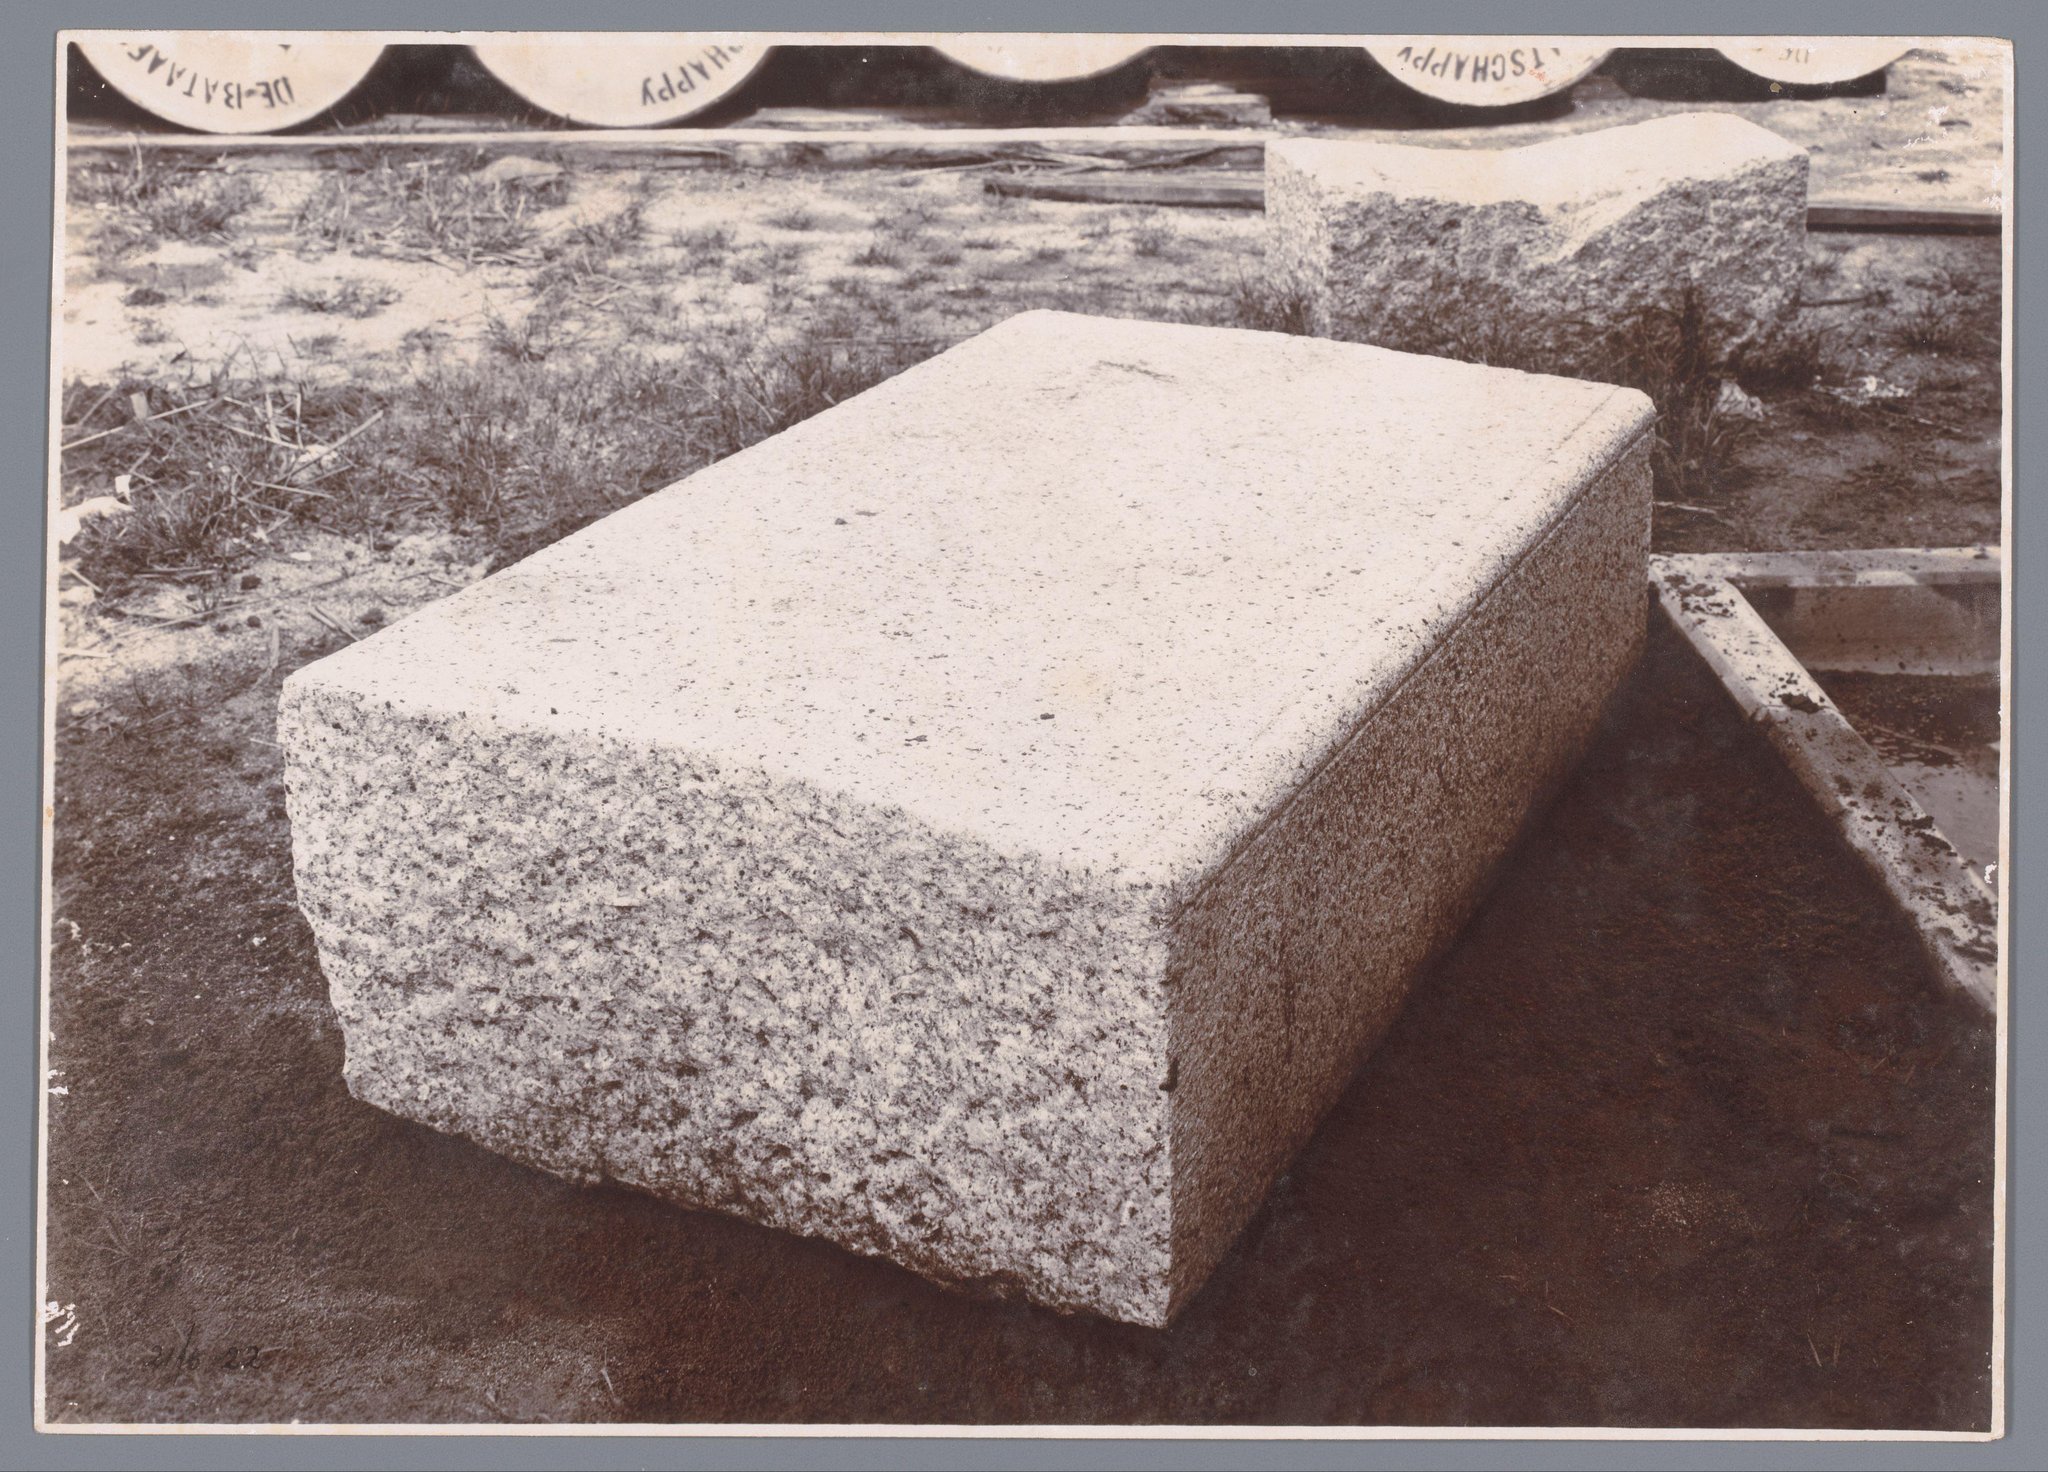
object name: photograph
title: Oceaanhaven Belawan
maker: Anonymous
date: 1906-1922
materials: photographic support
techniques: gelatin silver print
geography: belawan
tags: harbour, stone ~ building material, building-site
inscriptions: inscription: ‘No 173 Monster graniet voor dekzerken’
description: Een afdeksteen, geimporteerd uit China. Genummerd: 173. Onderdeel van de groep van losse foto's over de aanleg van de haven Belawan aan de kust voor Medan, Sumatra 1921-1922.